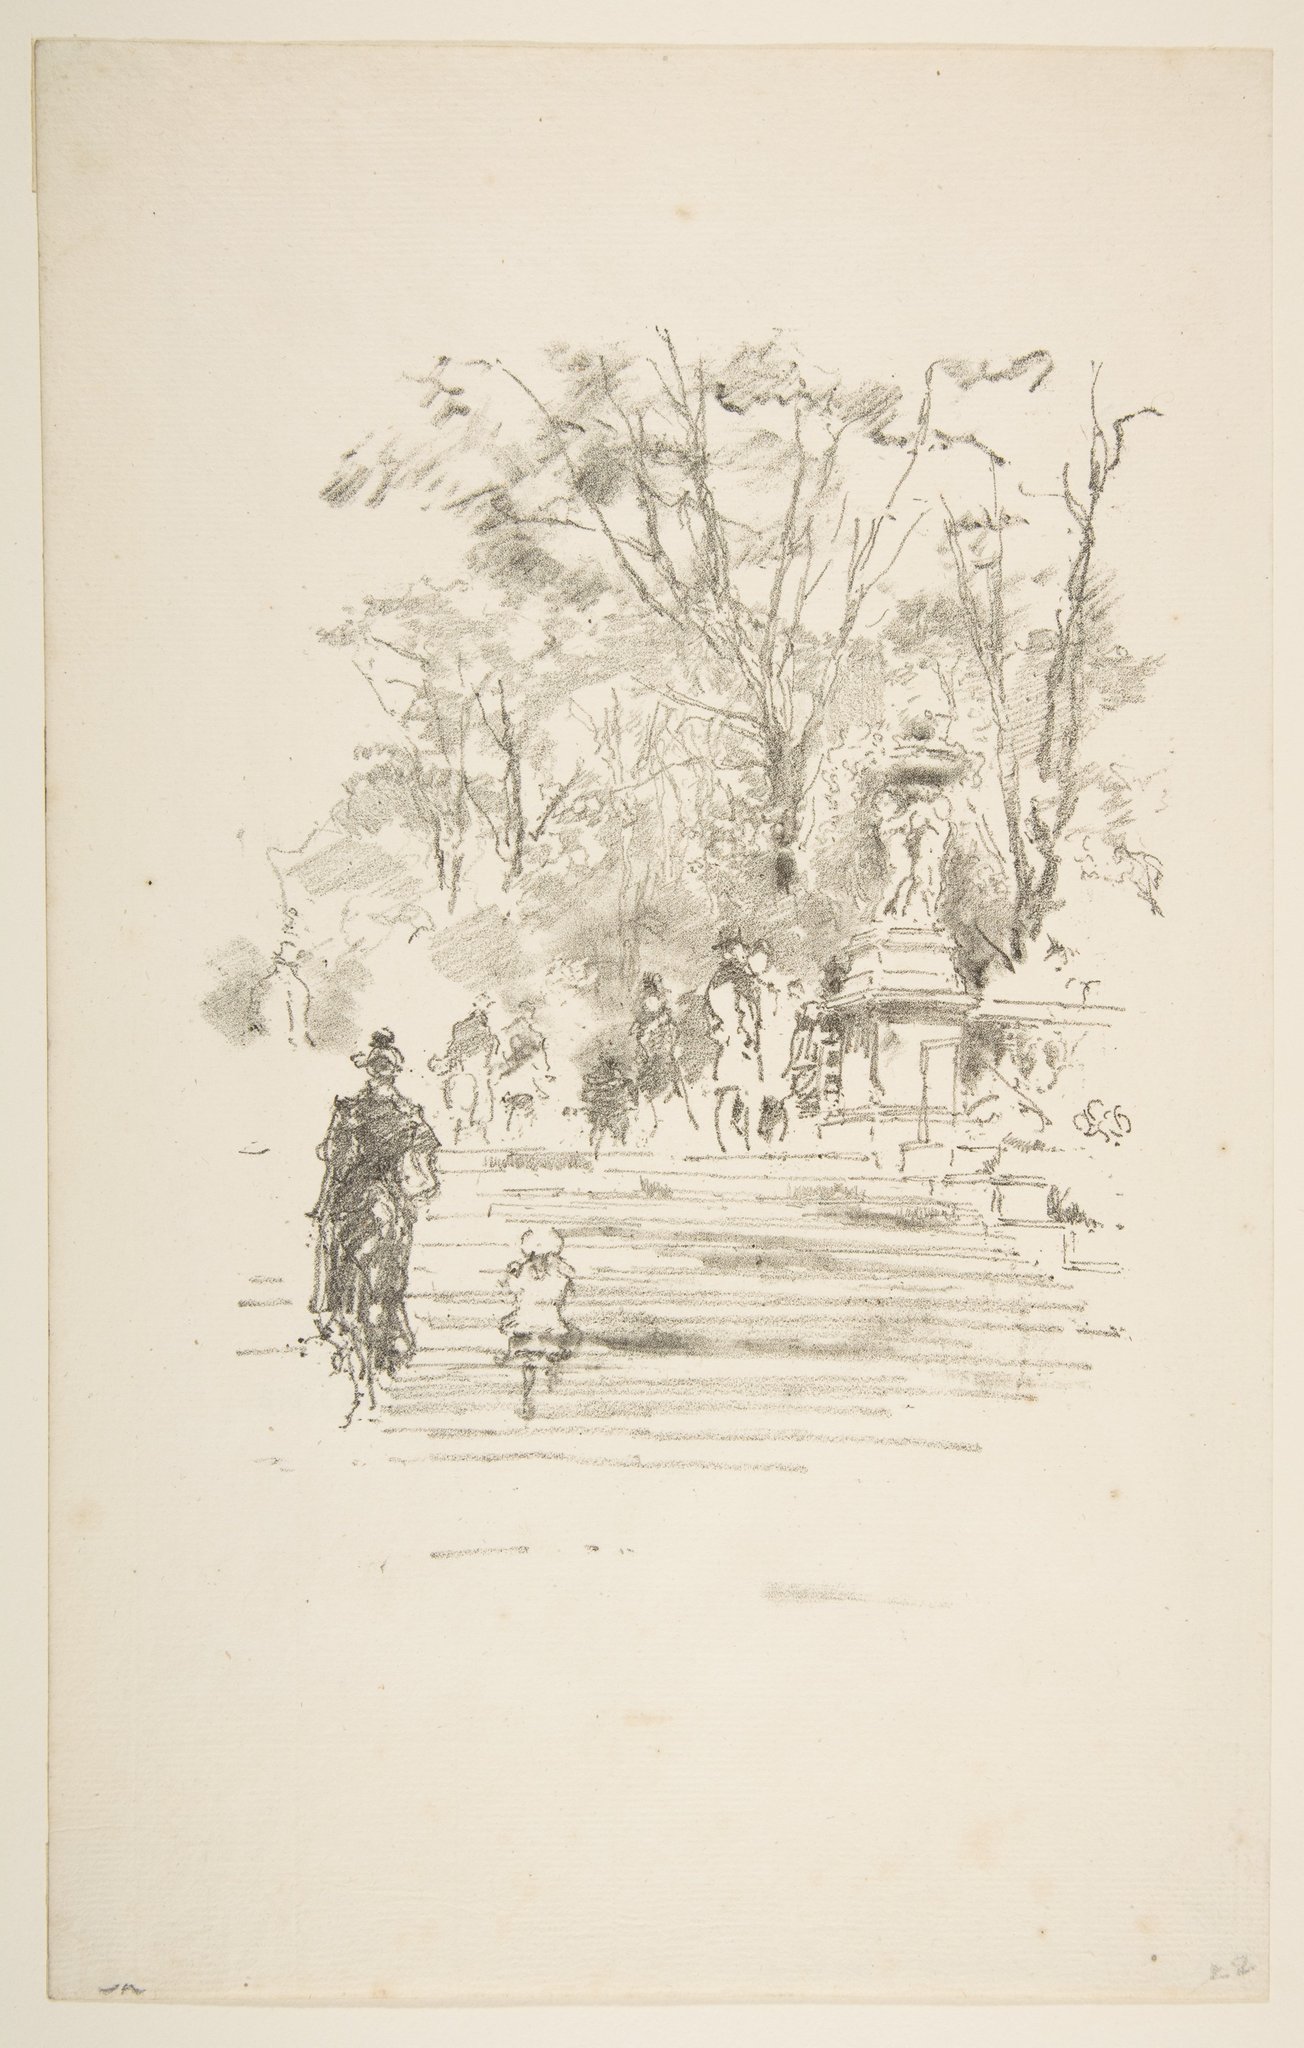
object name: print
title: The Steps, Luxembourg Gardens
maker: james mcneill whistler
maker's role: artist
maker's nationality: american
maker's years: 1834-1903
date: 1893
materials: ink, paper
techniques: printing, stumping, lithography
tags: human figures,gardens,trees